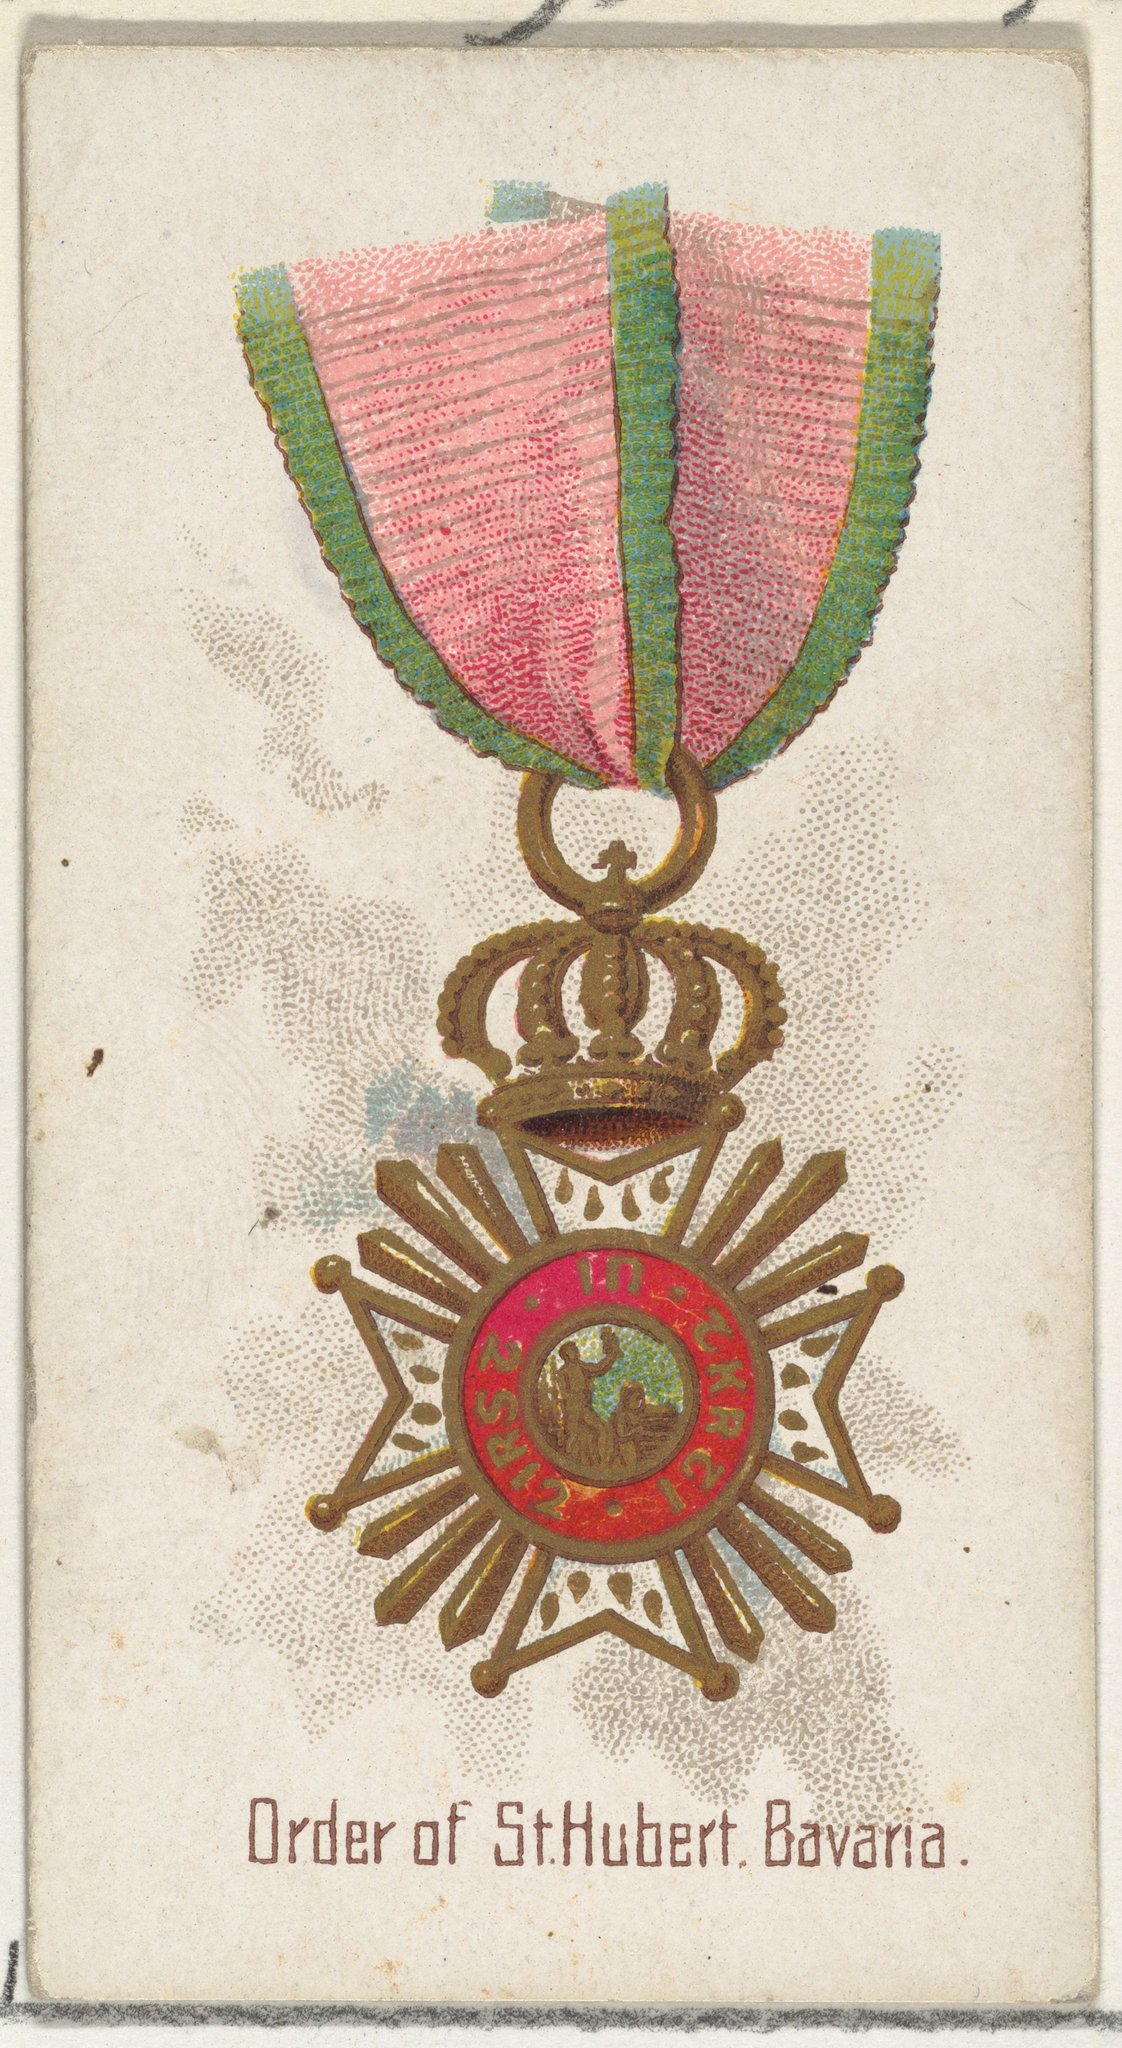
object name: print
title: Order of St. Hubert, Bavaria, from the World's Decorations series (N30) for Allen & Ginter Cigarettes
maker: allen & ginter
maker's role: publisher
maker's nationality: american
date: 1890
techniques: color lithograph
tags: medals